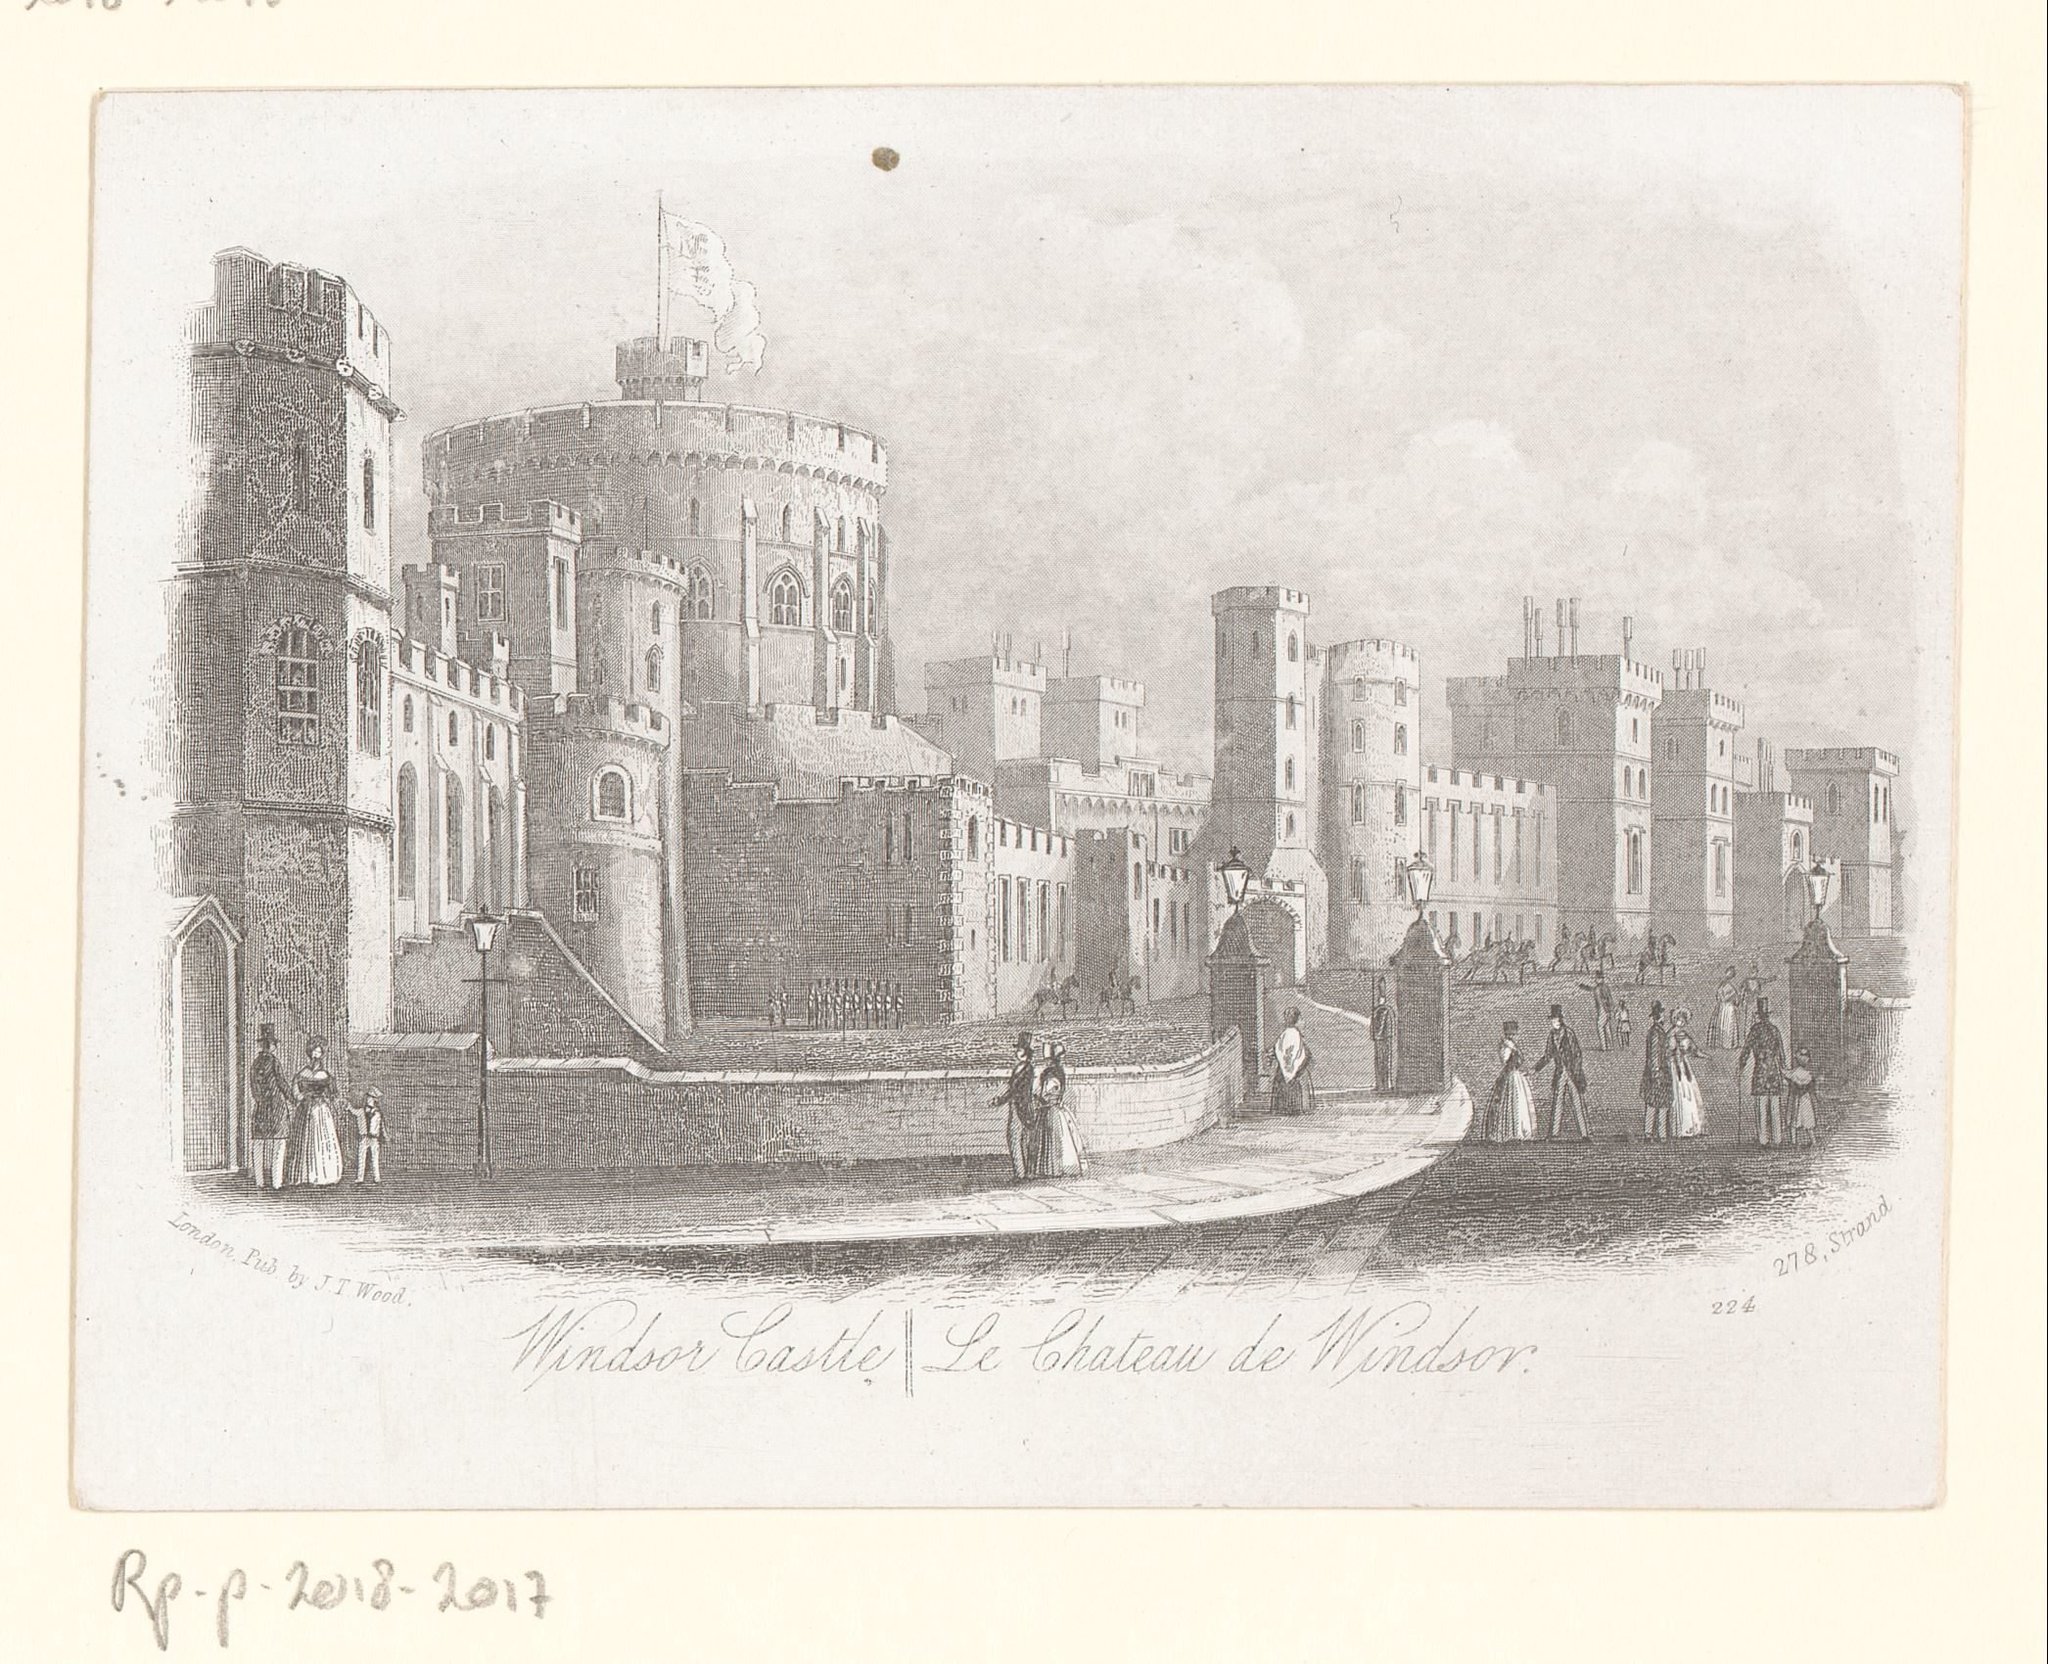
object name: print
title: Gezicht op Windsor Castle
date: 1800-1899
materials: paper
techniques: engraving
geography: london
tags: castle, palace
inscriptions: collector's mark: Lugt 2228